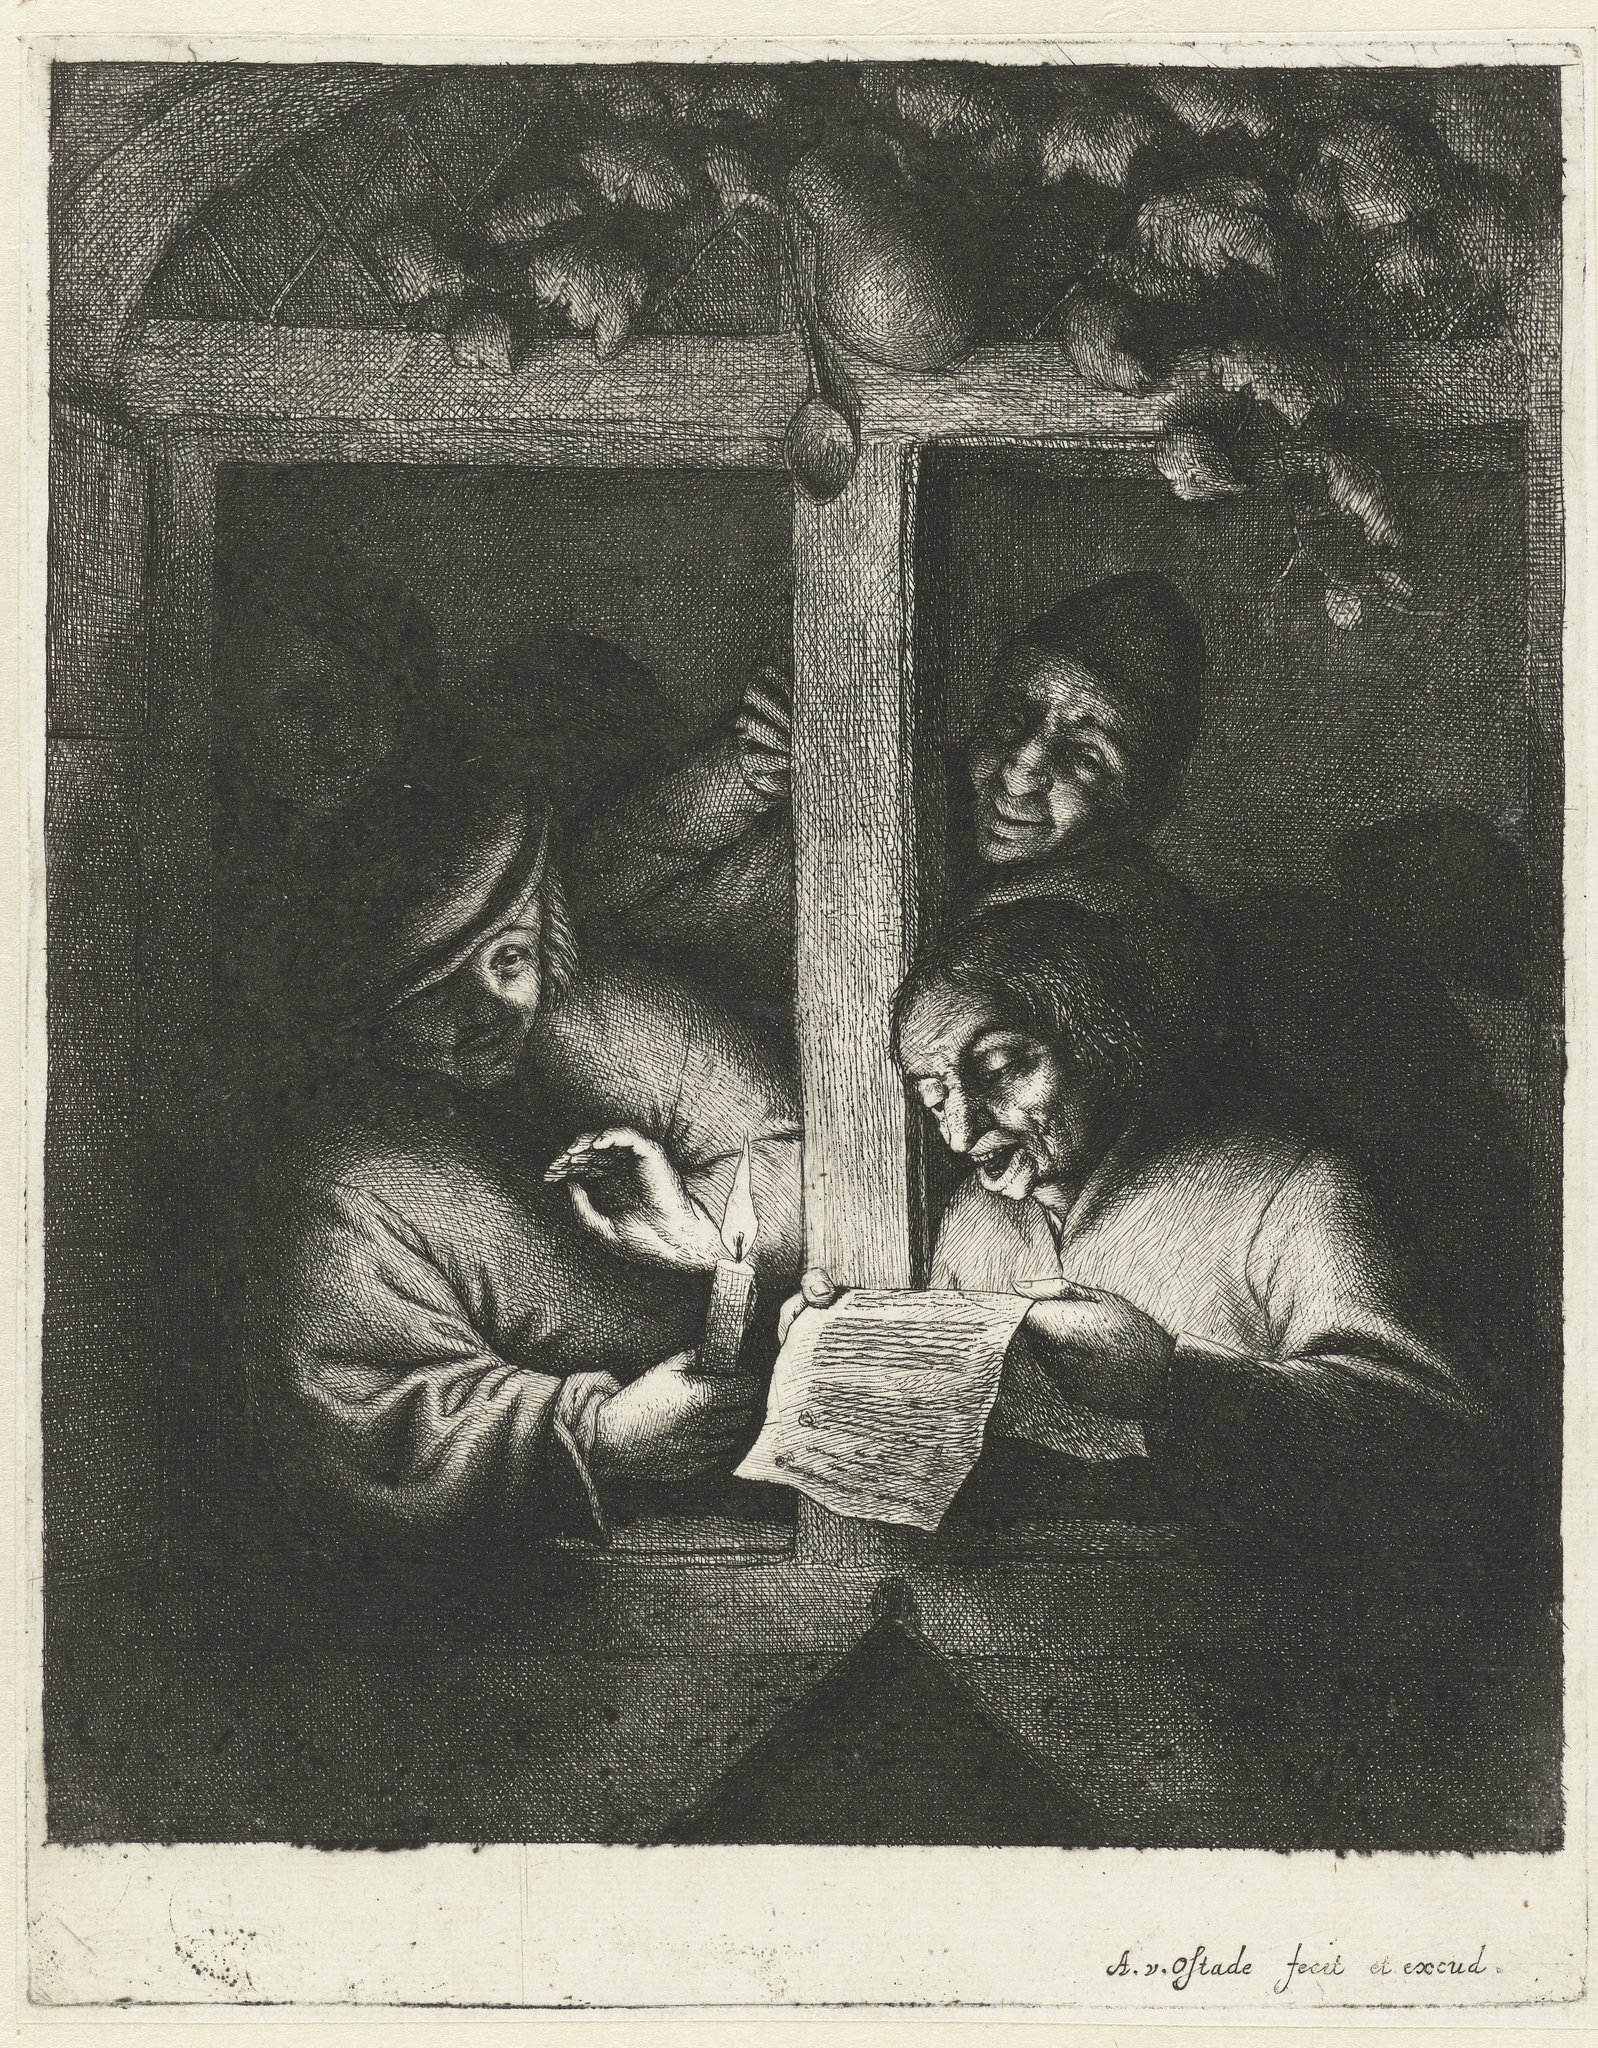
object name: print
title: De zangers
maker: adriaen van ostade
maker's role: draughtsman, painter, print maker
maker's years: 1610-1685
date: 1666-1670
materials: paper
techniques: etching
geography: haarlem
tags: vocal music, singing, human figure at (open) window, seen from outside - aa - feigned window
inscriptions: collector's mark: Lugt 240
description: De drie zangers in een open raam is een satire op de literaire bijeenkomsten van de rederijkers. Het ruitvormige blazoen onder het raam verwijst hiernaar, normaal gesproken droeg dit schild het wapen van de rederijkers. Ook de wijnkruik kan met hen in verband gebracht worden, de wijn bracht inspiratie voor hun activiteiten.